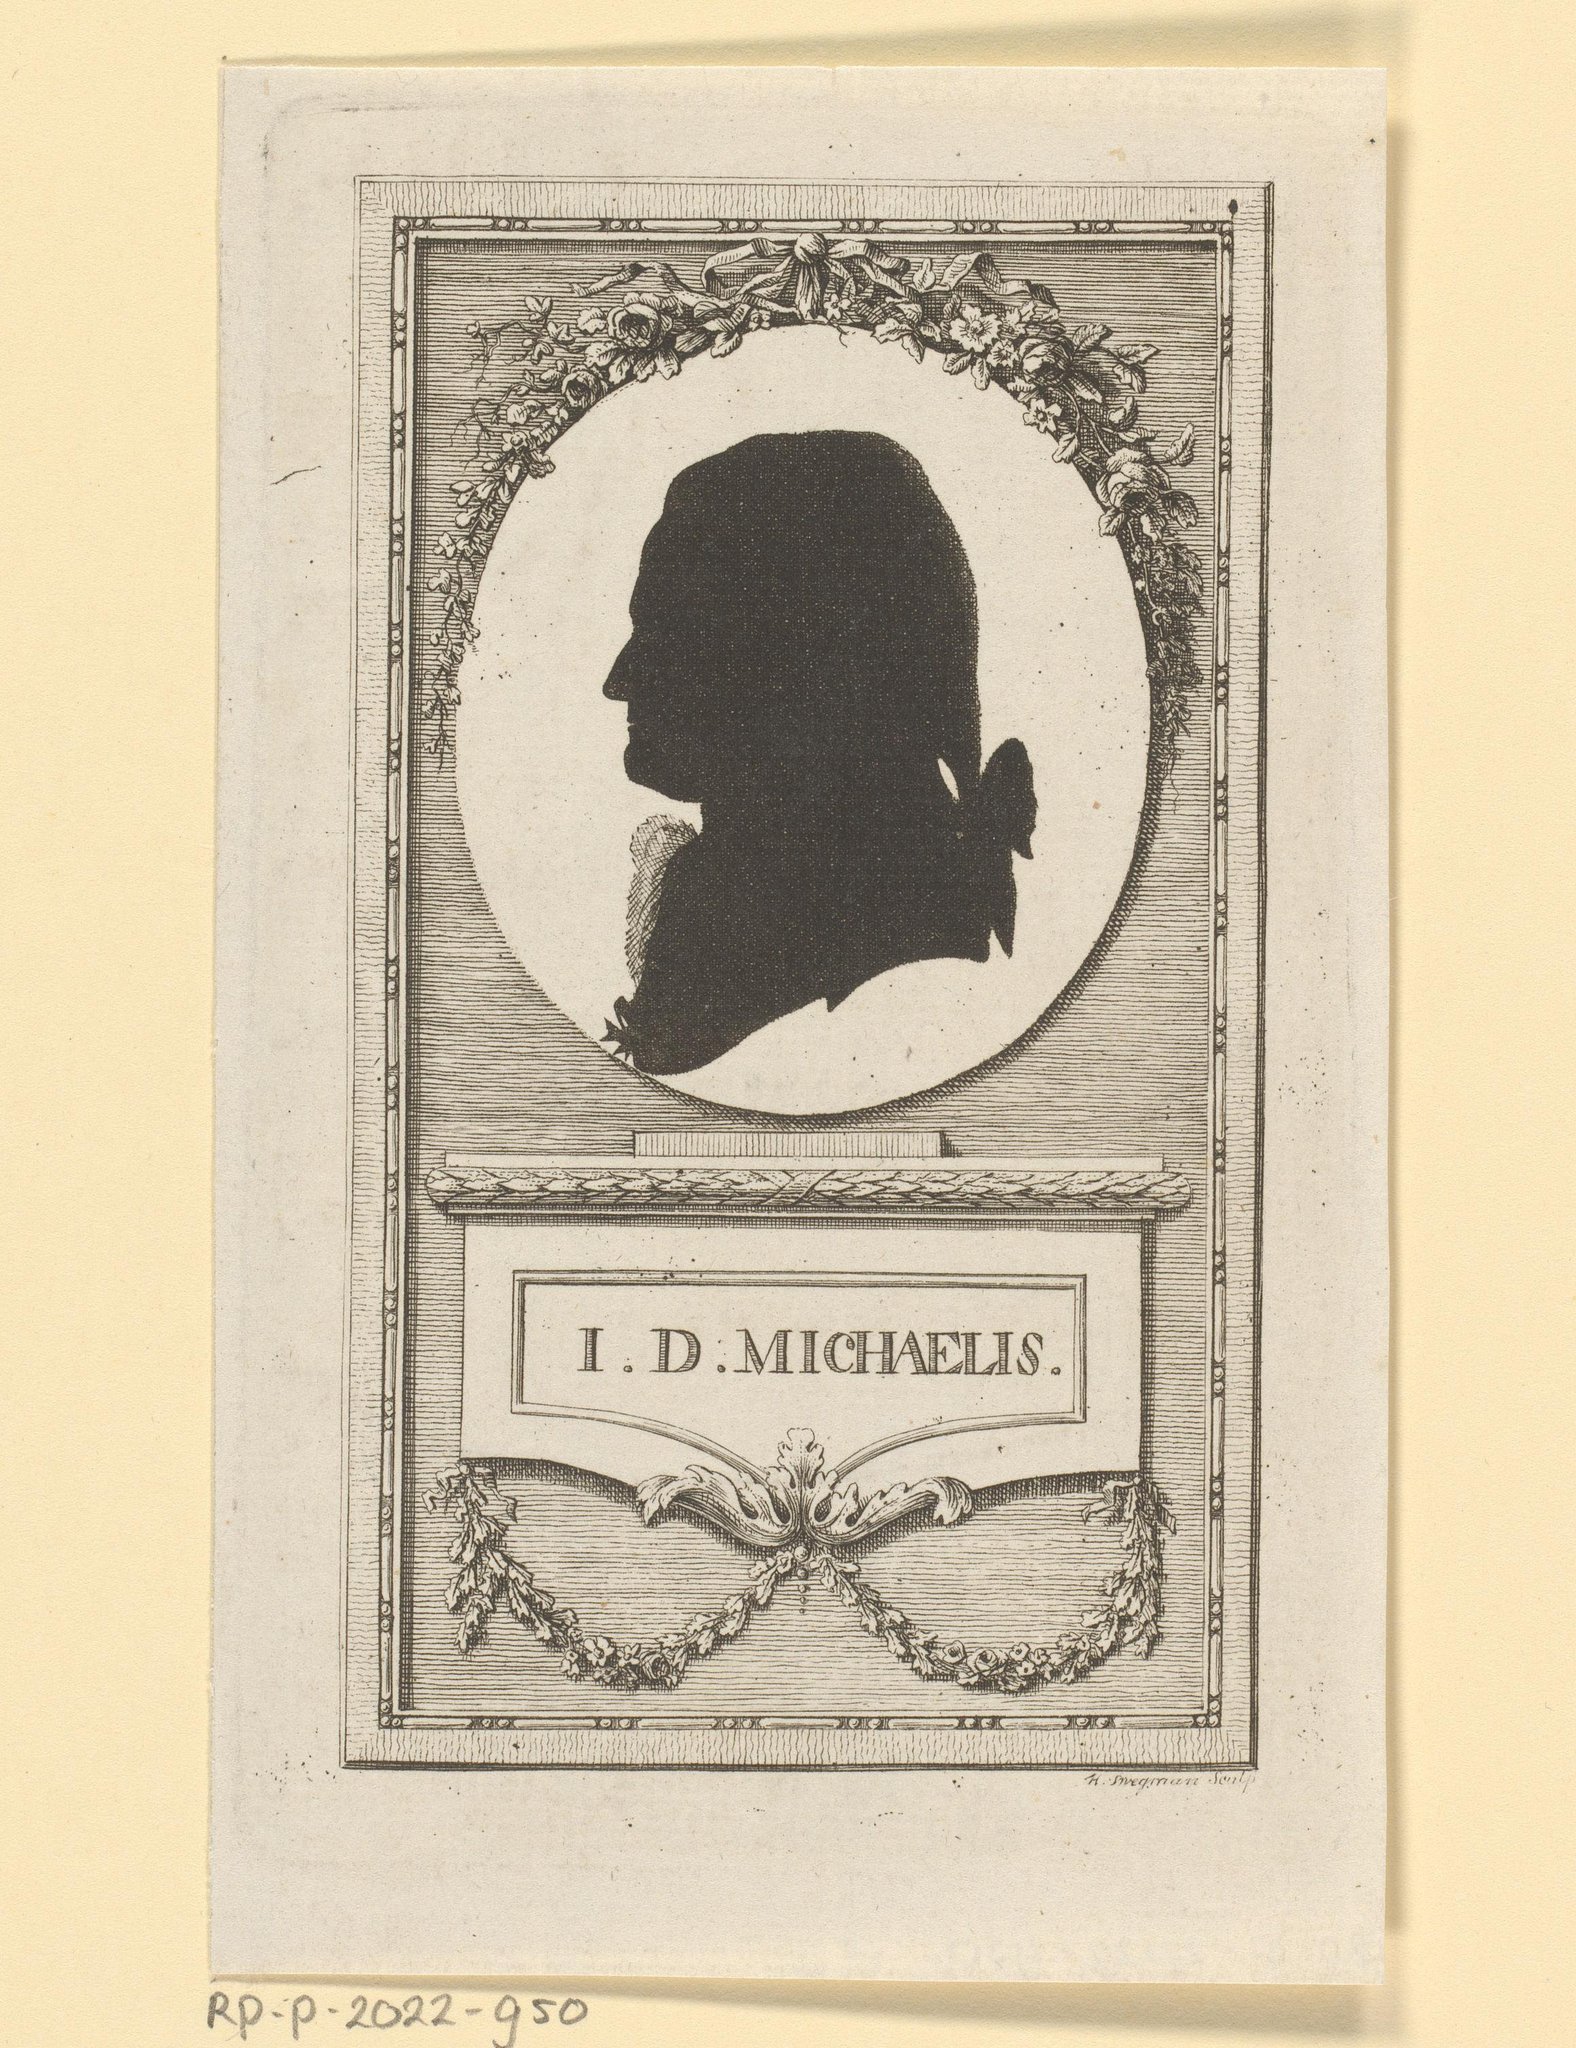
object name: print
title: Silhouetportret van Johann David Michaelis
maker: hendrik schwegman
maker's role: draughtsman, print maker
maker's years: 1761-1816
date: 1786-1806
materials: paper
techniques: etching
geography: haarlem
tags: theologian, historical persons